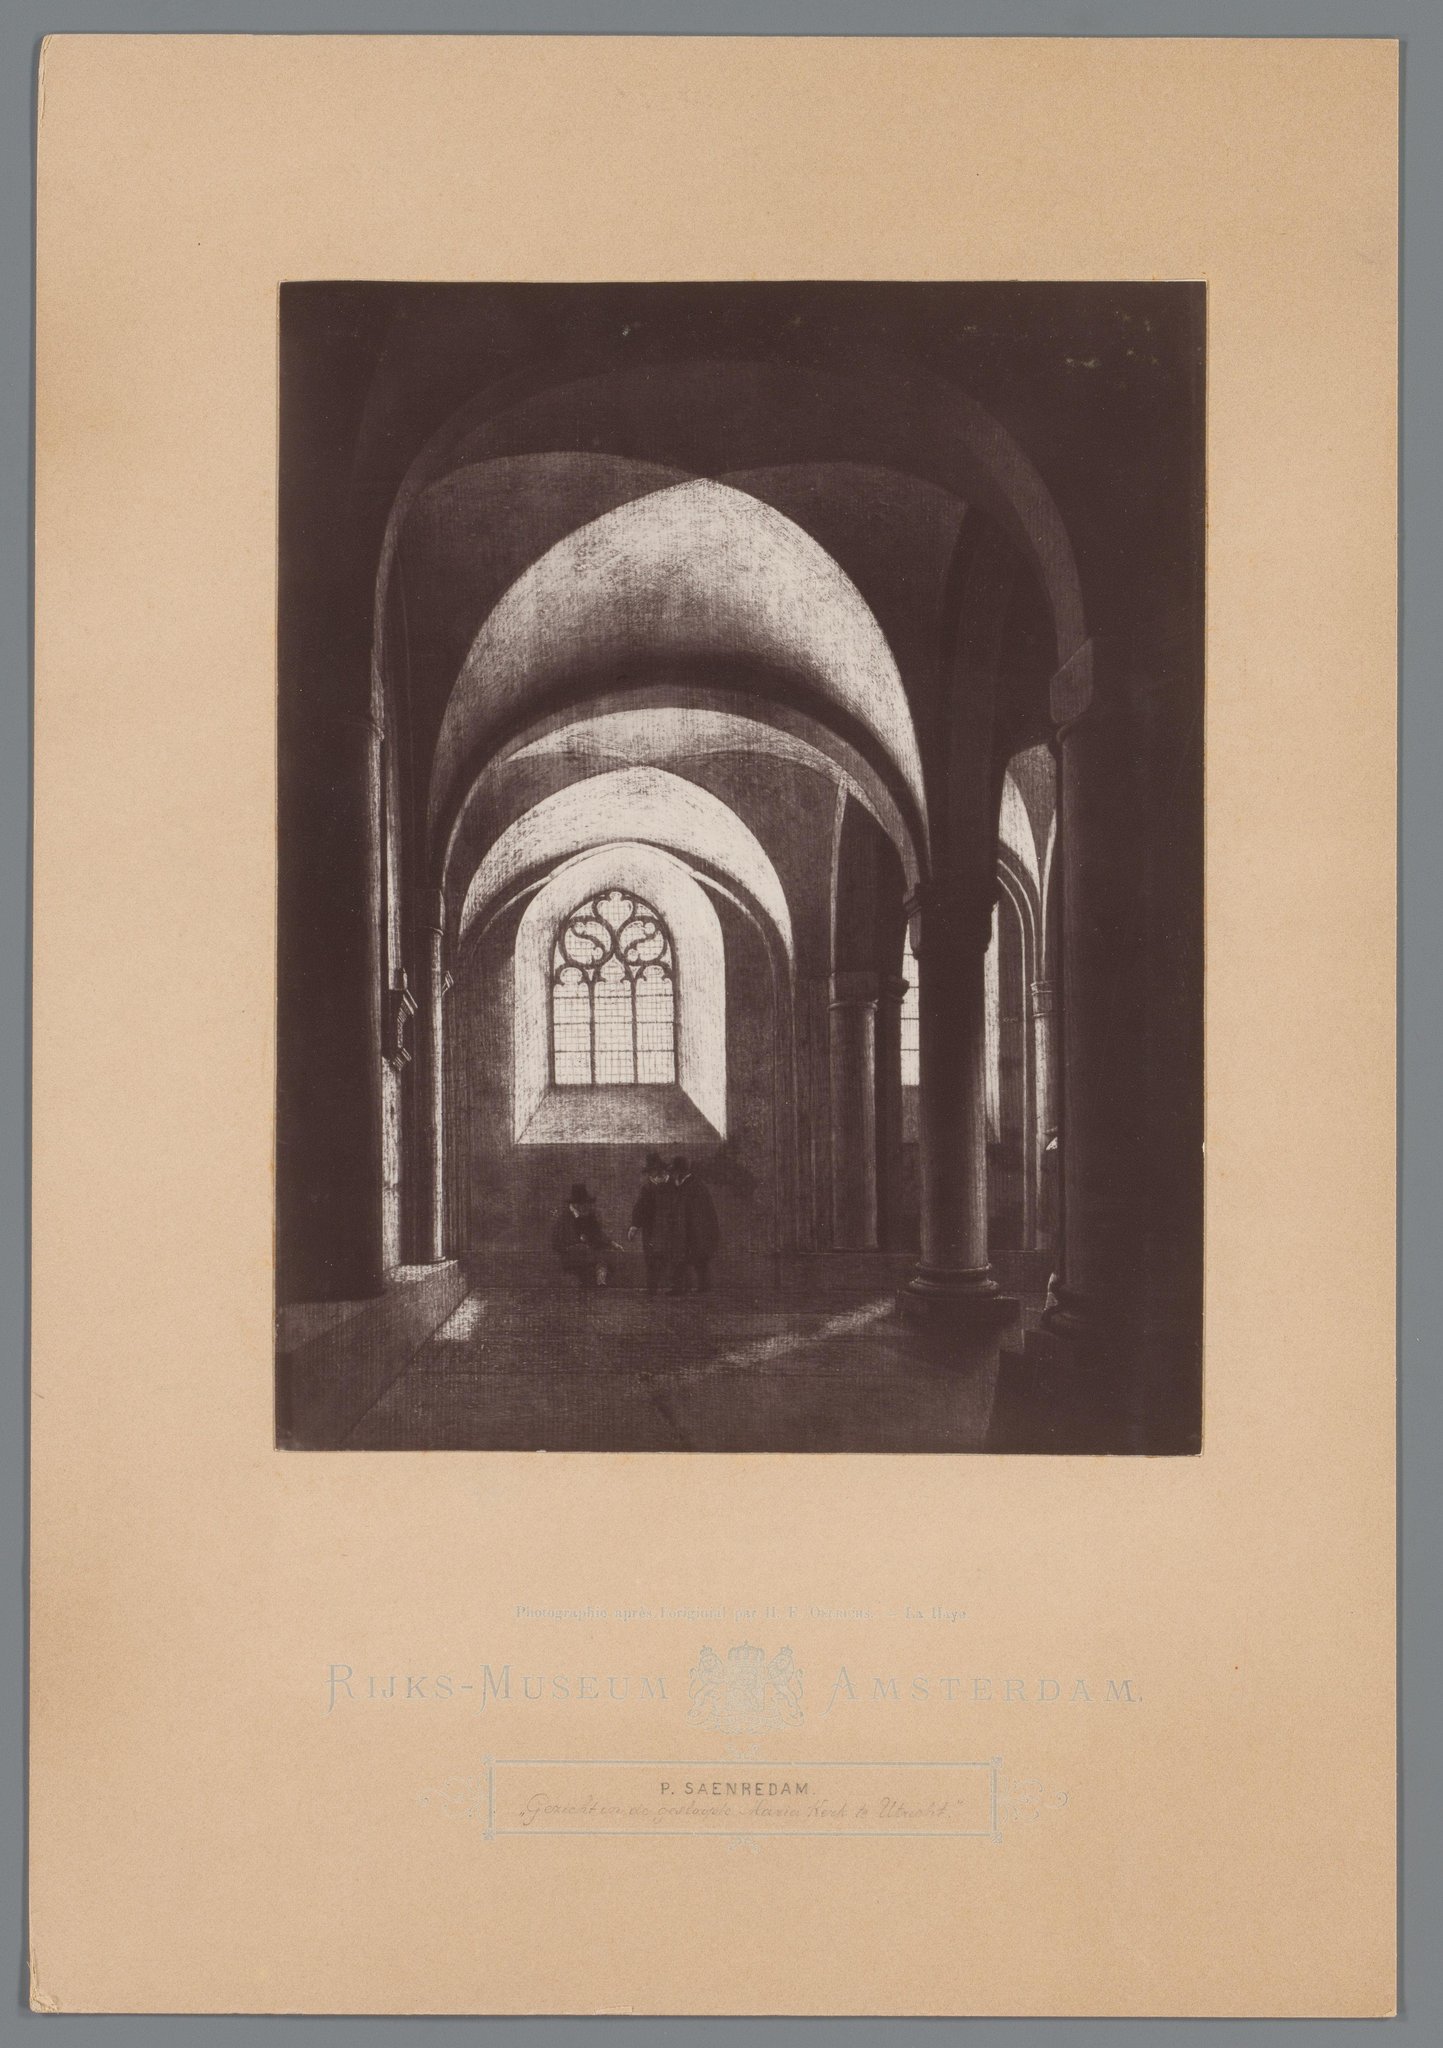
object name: reproduction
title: Fotoreproductie van een schilderij van de westelijke traveeën van de zuidelijke beuk van de Mariakerk te Utrecht door Pieter Jansz. Saenredam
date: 1885-1915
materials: paper, cardboard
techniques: collodion silver print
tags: interior of church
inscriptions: inscription: ‘Photographie après l'original par H.F. OELRICHS. - La Haye./ RIJKS-MUSEUM AMSTERDAM/ P. SAENREDAM./ "Gezicht in de gesloopte Maria Kerk te Utrecht."’